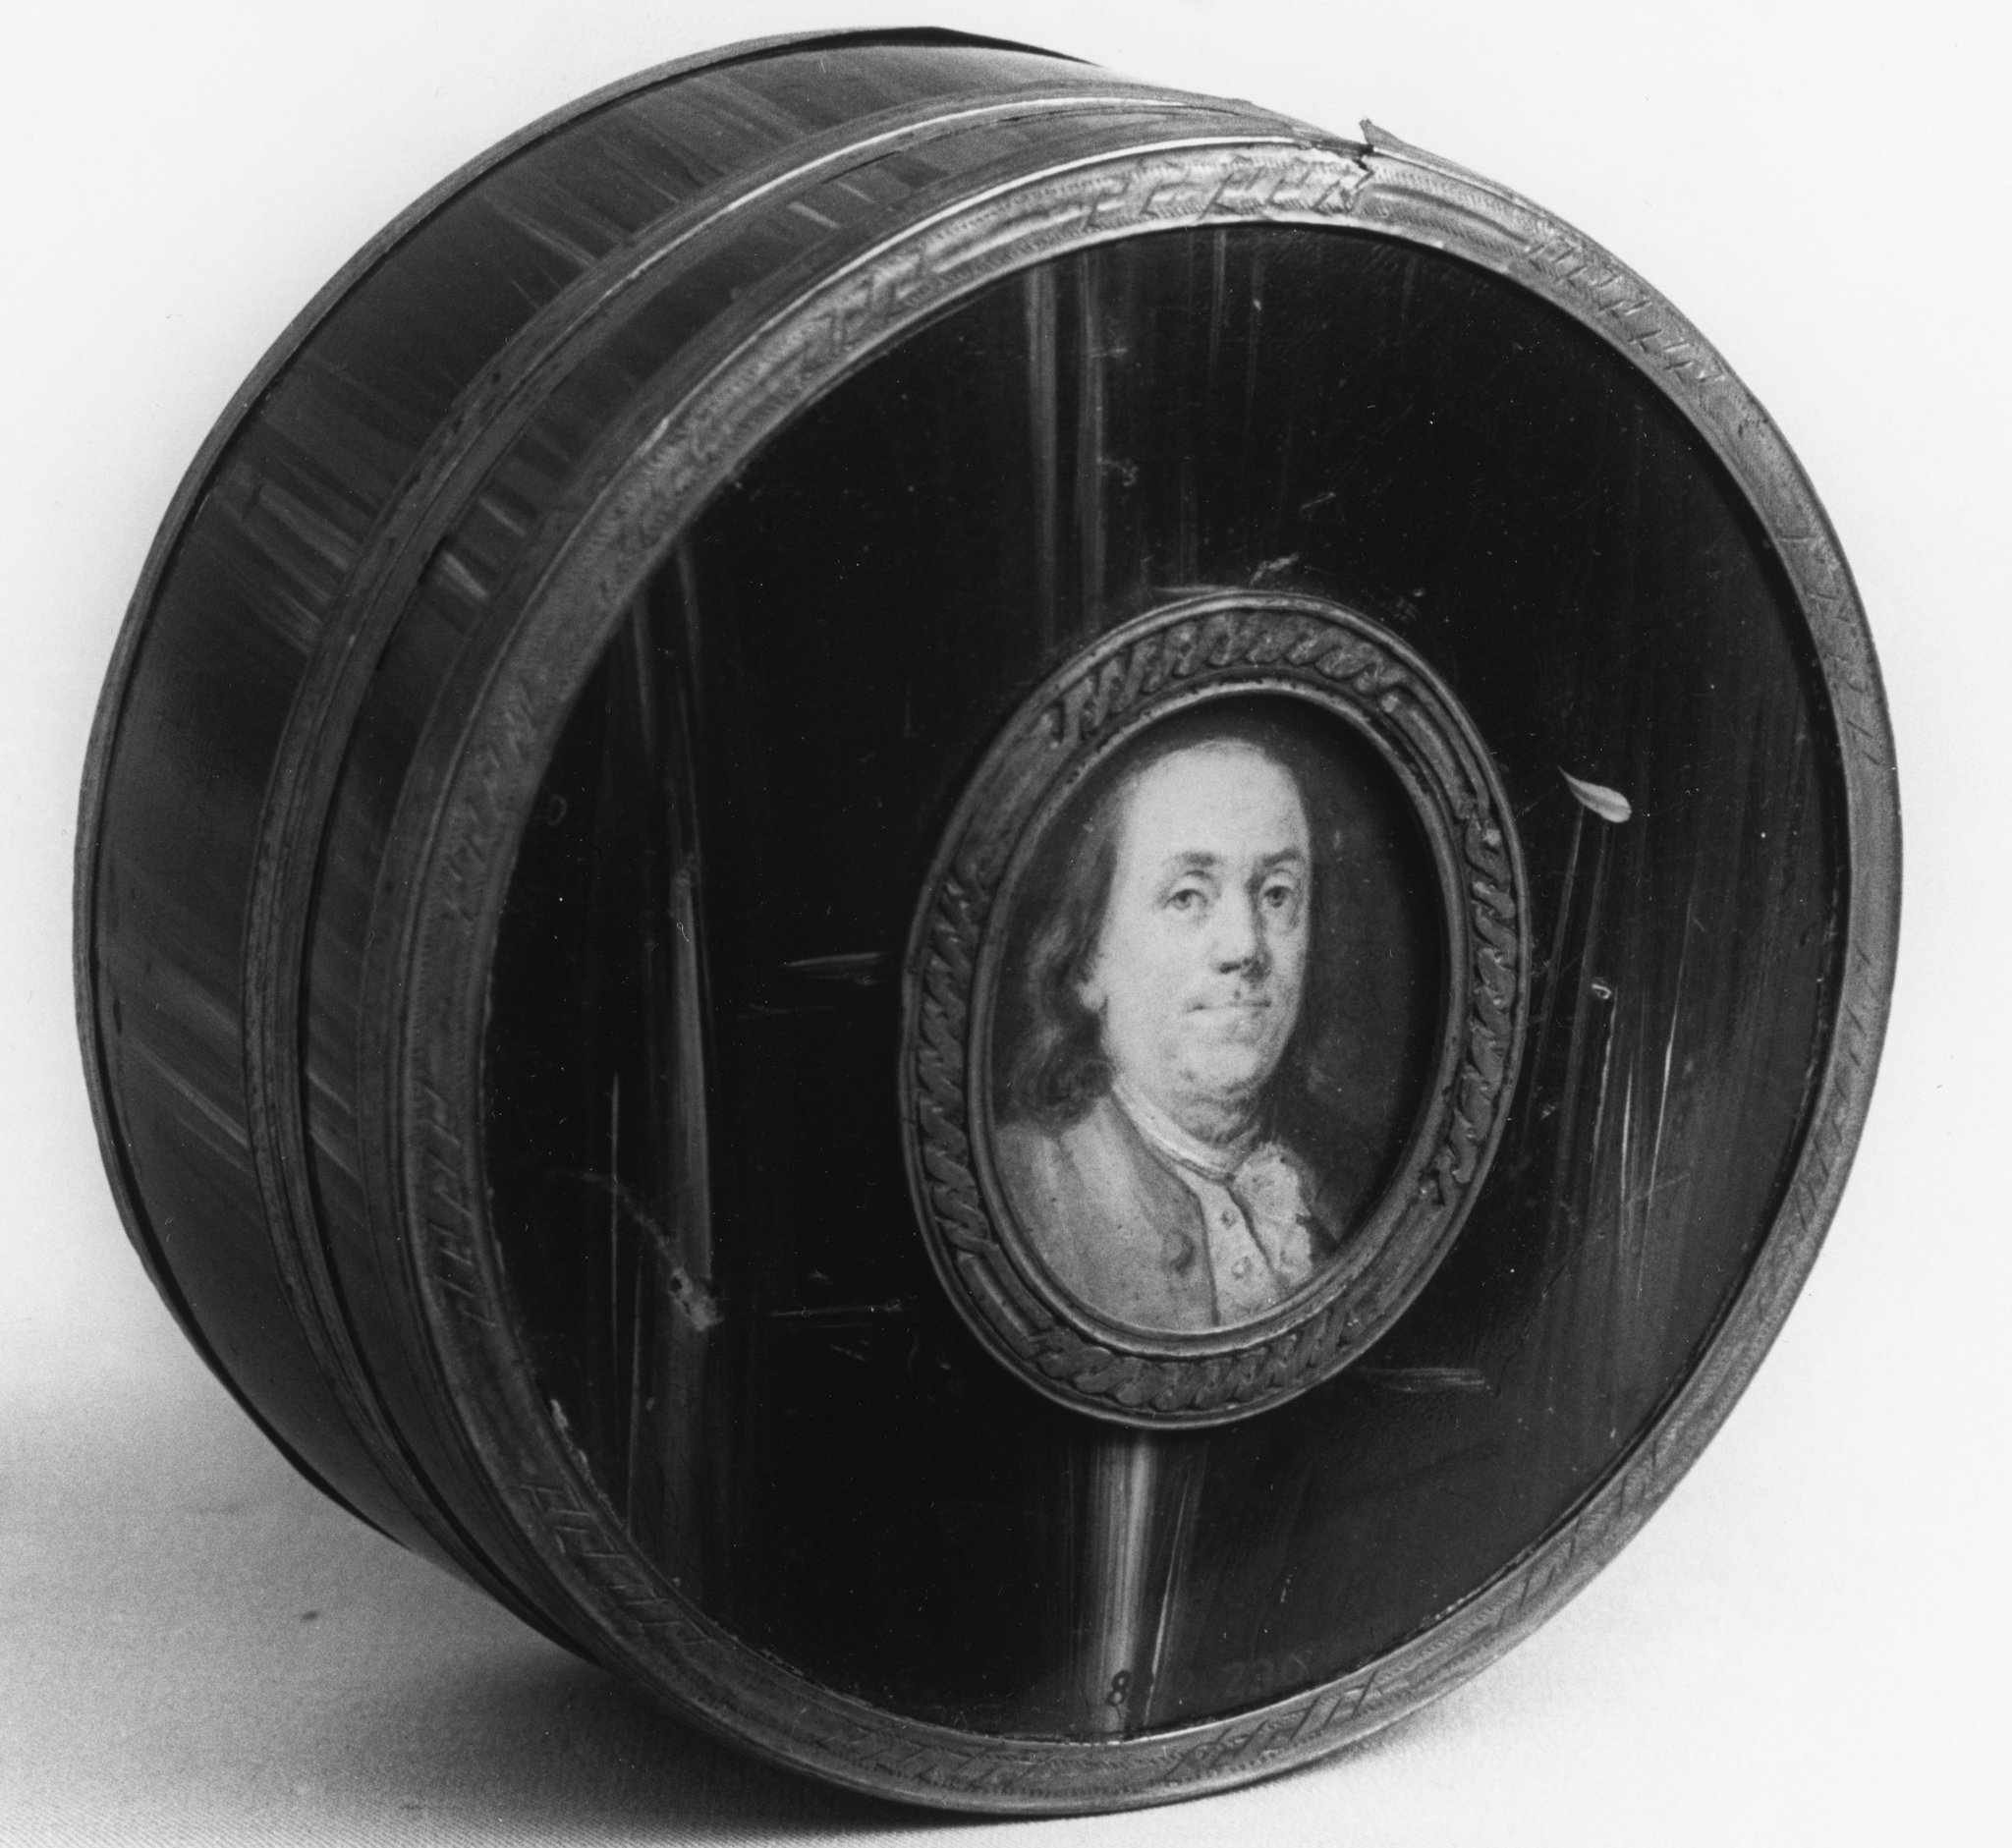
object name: box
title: Box with Medallion Top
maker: joseph siffred duplessis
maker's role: maker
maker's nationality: french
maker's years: 1725-1802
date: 1770-1800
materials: ivory, paper, silver, shell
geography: france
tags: benjamin franklin,men,portraits